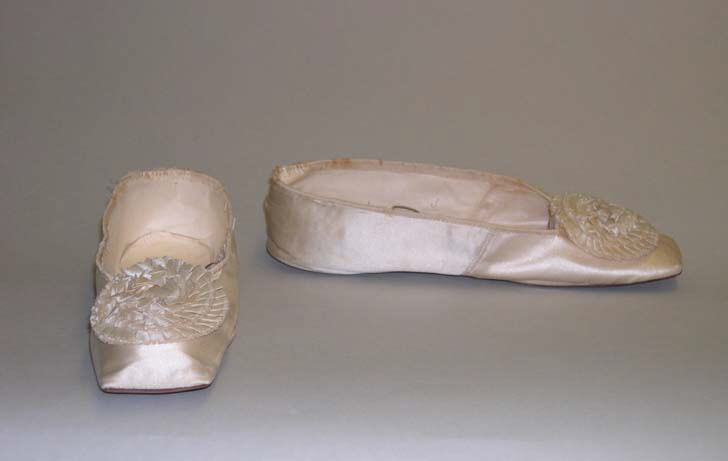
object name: slipper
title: Slippers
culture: american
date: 1835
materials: leather, silk